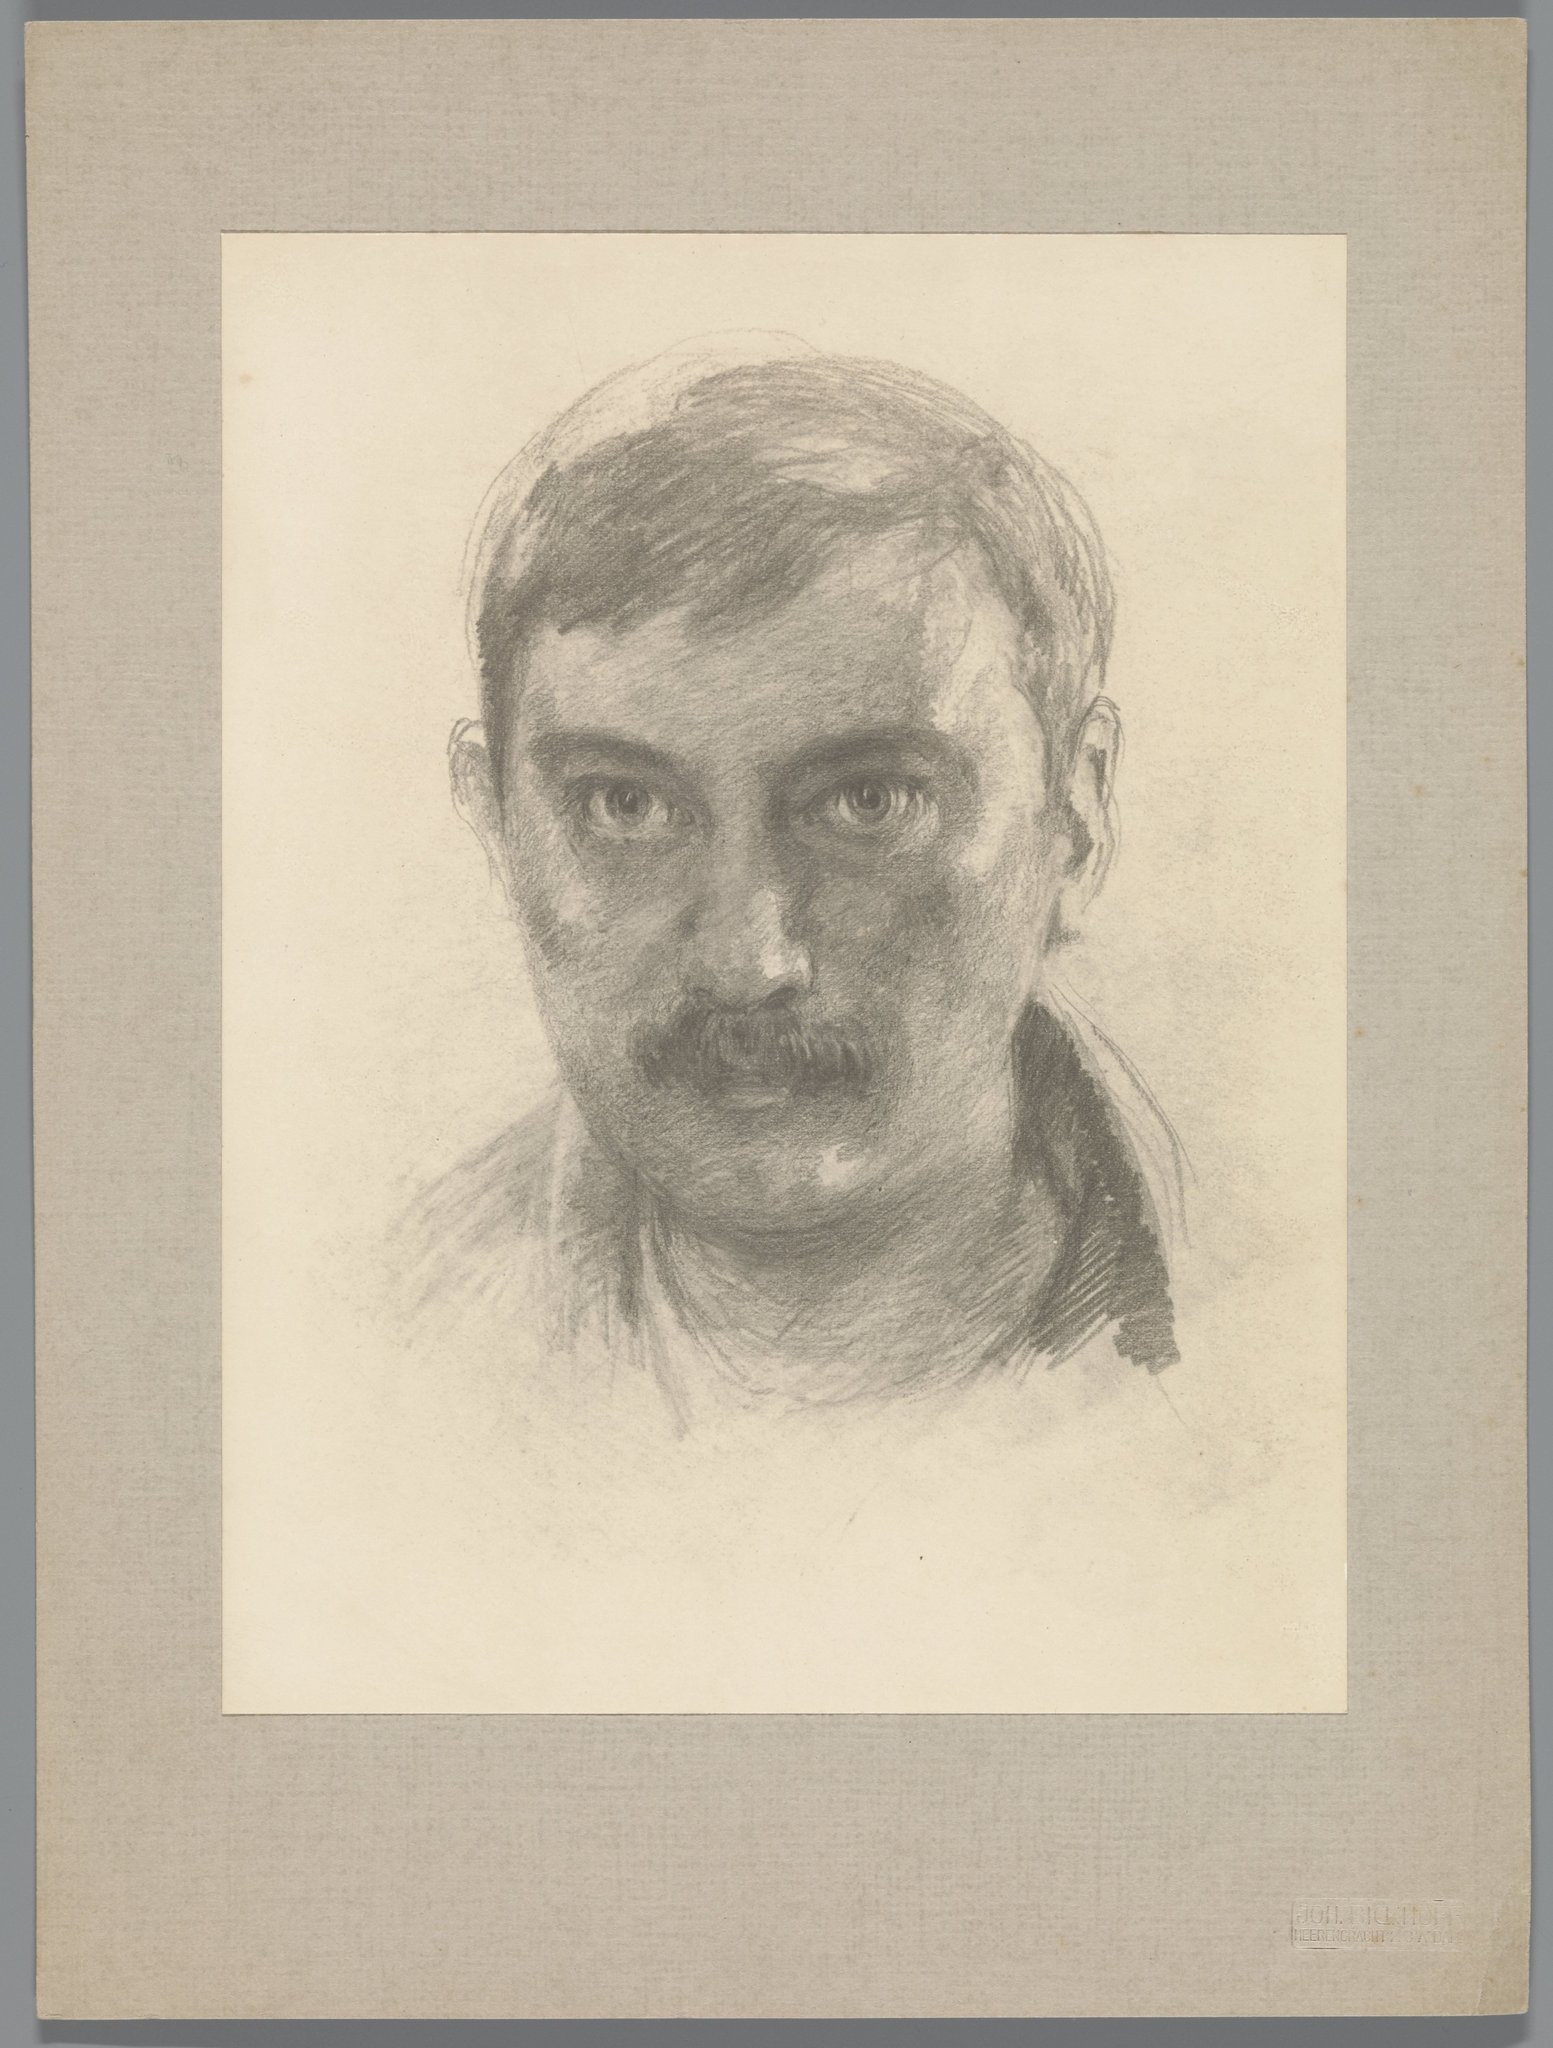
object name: photograph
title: Reproductie naar tekening met zelfportret van Willem Witsen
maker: johan bickhoff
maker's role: fotograaf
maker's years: 1881-1968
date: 1860-1915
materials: paper, photographic support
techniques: gelatin silver print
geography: netherlands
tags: amsterdam, painter, print maker, draughtsman, willem witsen